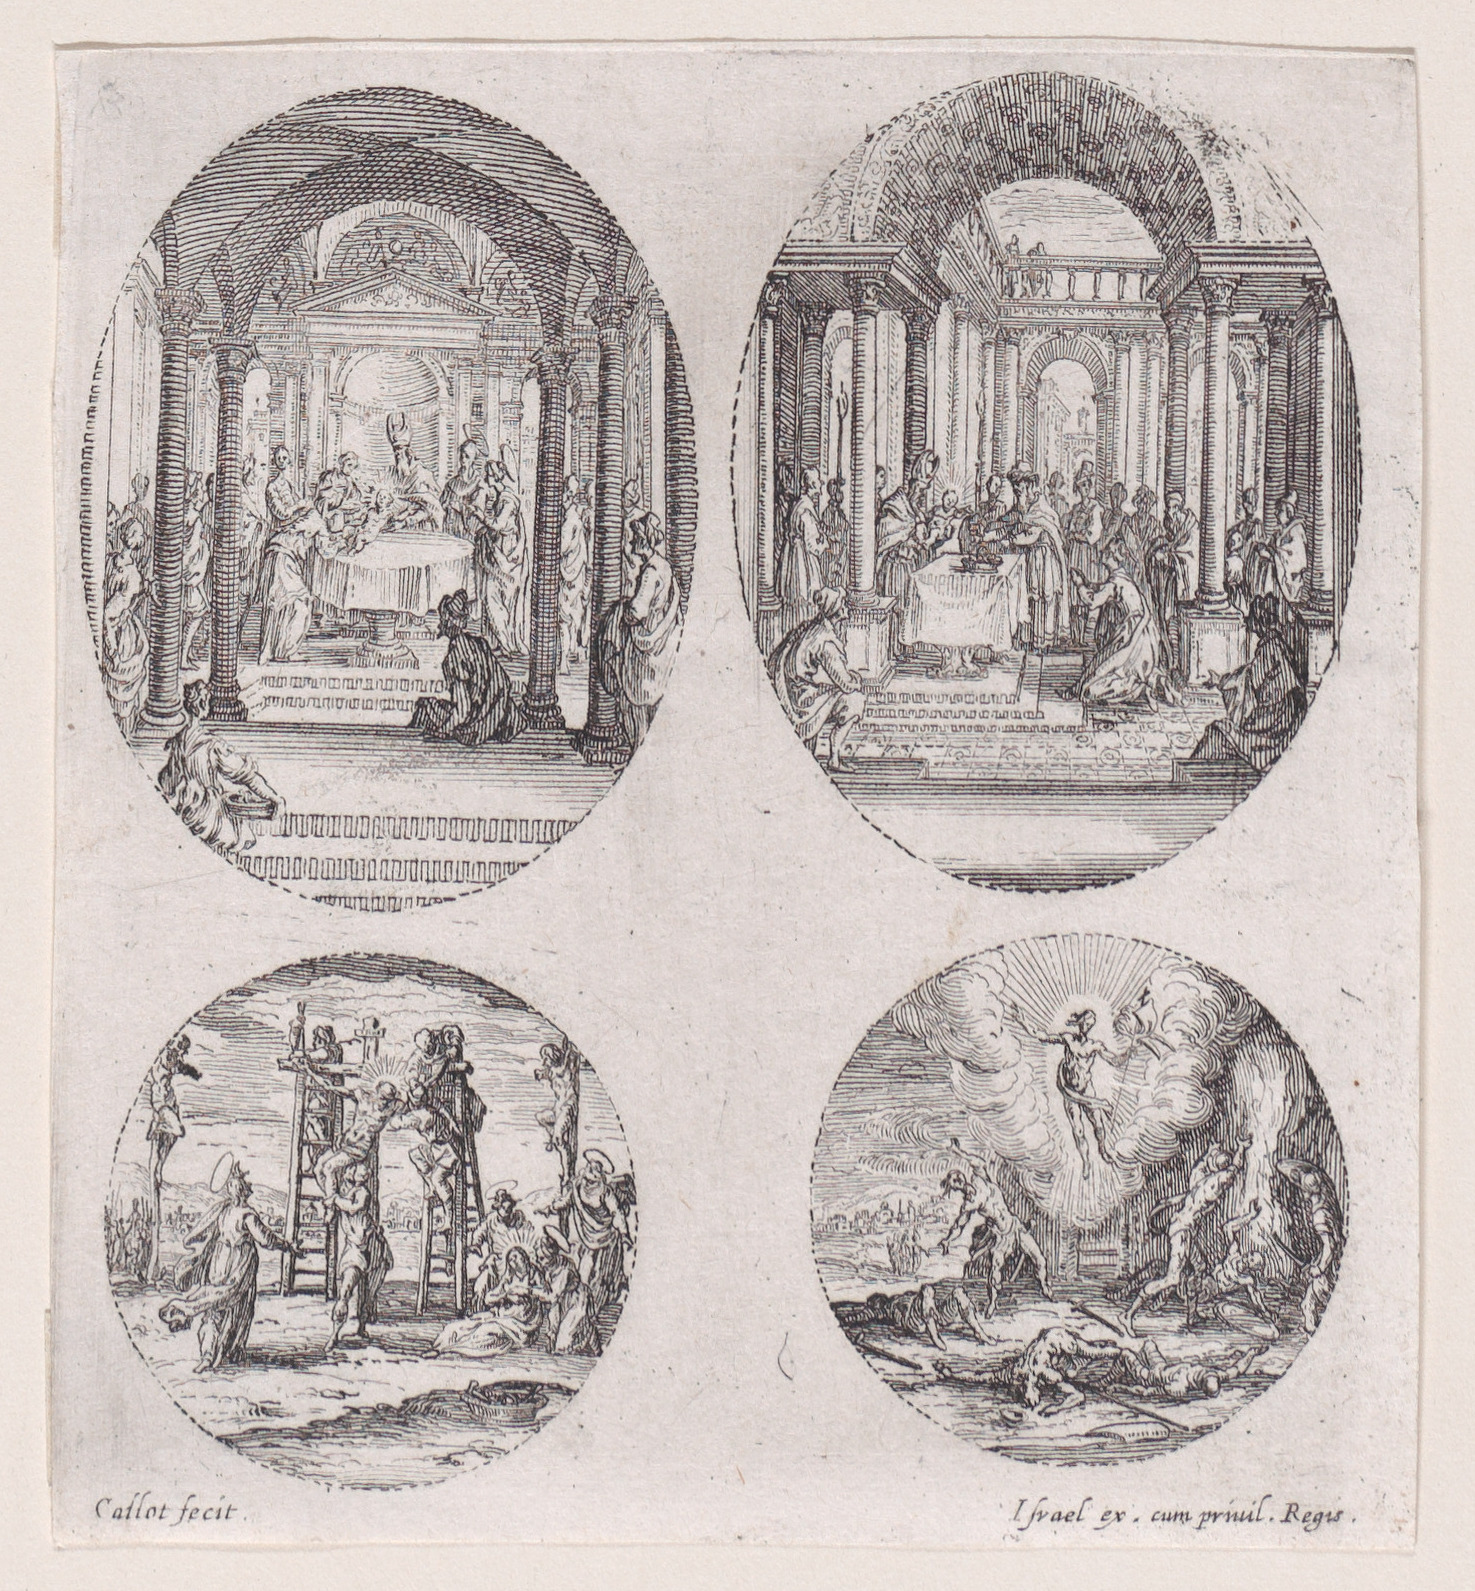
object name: print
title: Oval Medallions and Rondels, from "Variae tum Passionis Christi tum vitae beatae Mariae Virginis; Les Mystères de la Passion suite appelée aussi Mystères de la Vie de Jésus et Mystères de la Vie de Jésus et de la Vie de la Ste. Vierge" (The Mysteries of the Passion, also called the Mysteries of the Life of Jesus, and the Mysteries of the Life of Jesus and of the Virgin)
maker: jacques callot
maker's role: artist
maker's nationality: french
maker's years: 1592-1635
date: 1631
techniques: engraving, etching